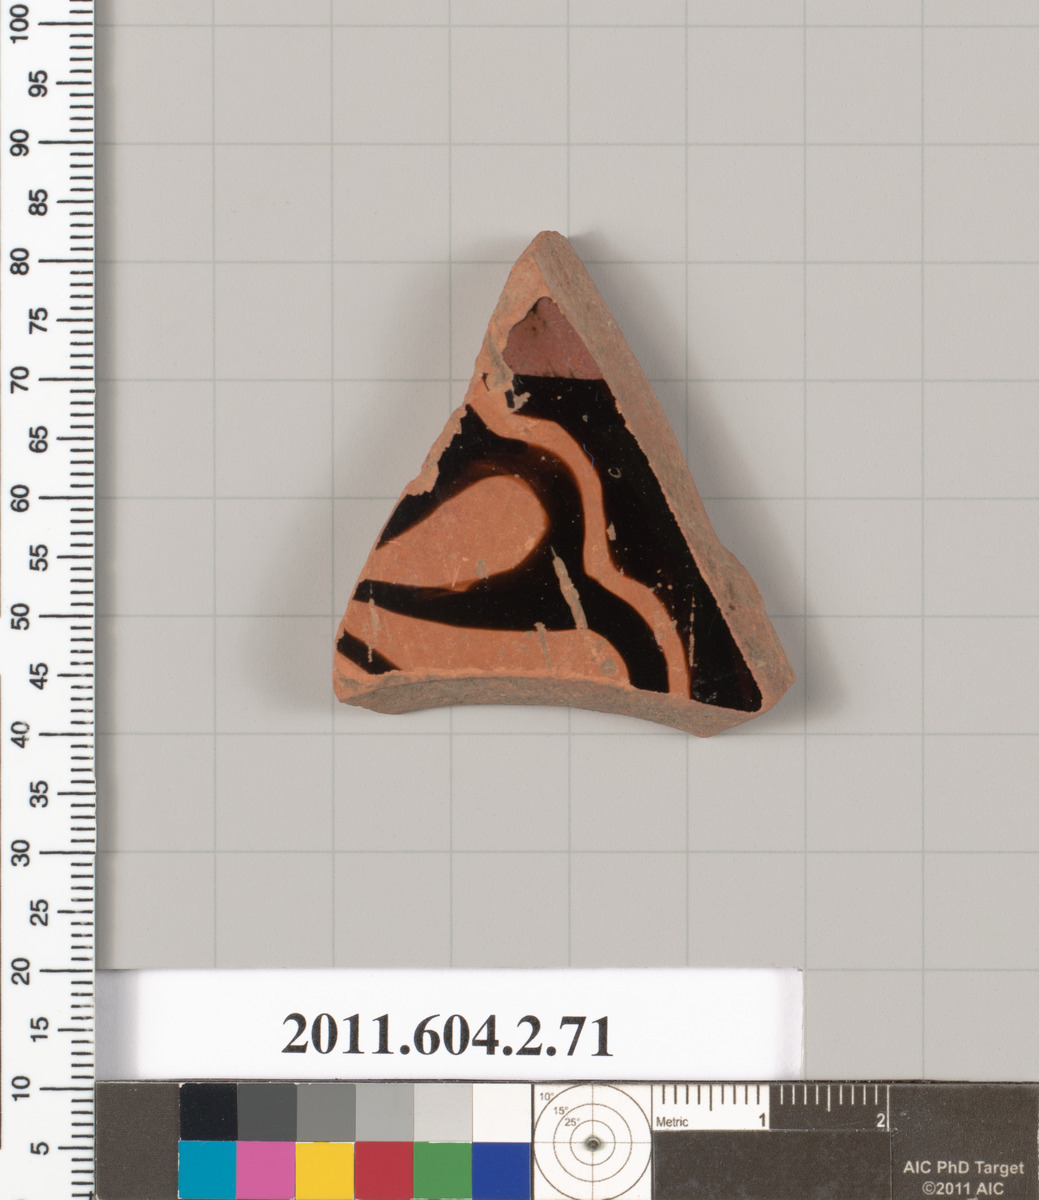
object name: amphora fragment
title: Terracotta fragment of an amphora (jar)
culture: greek, attic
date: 534-468 BCE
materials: terracotta